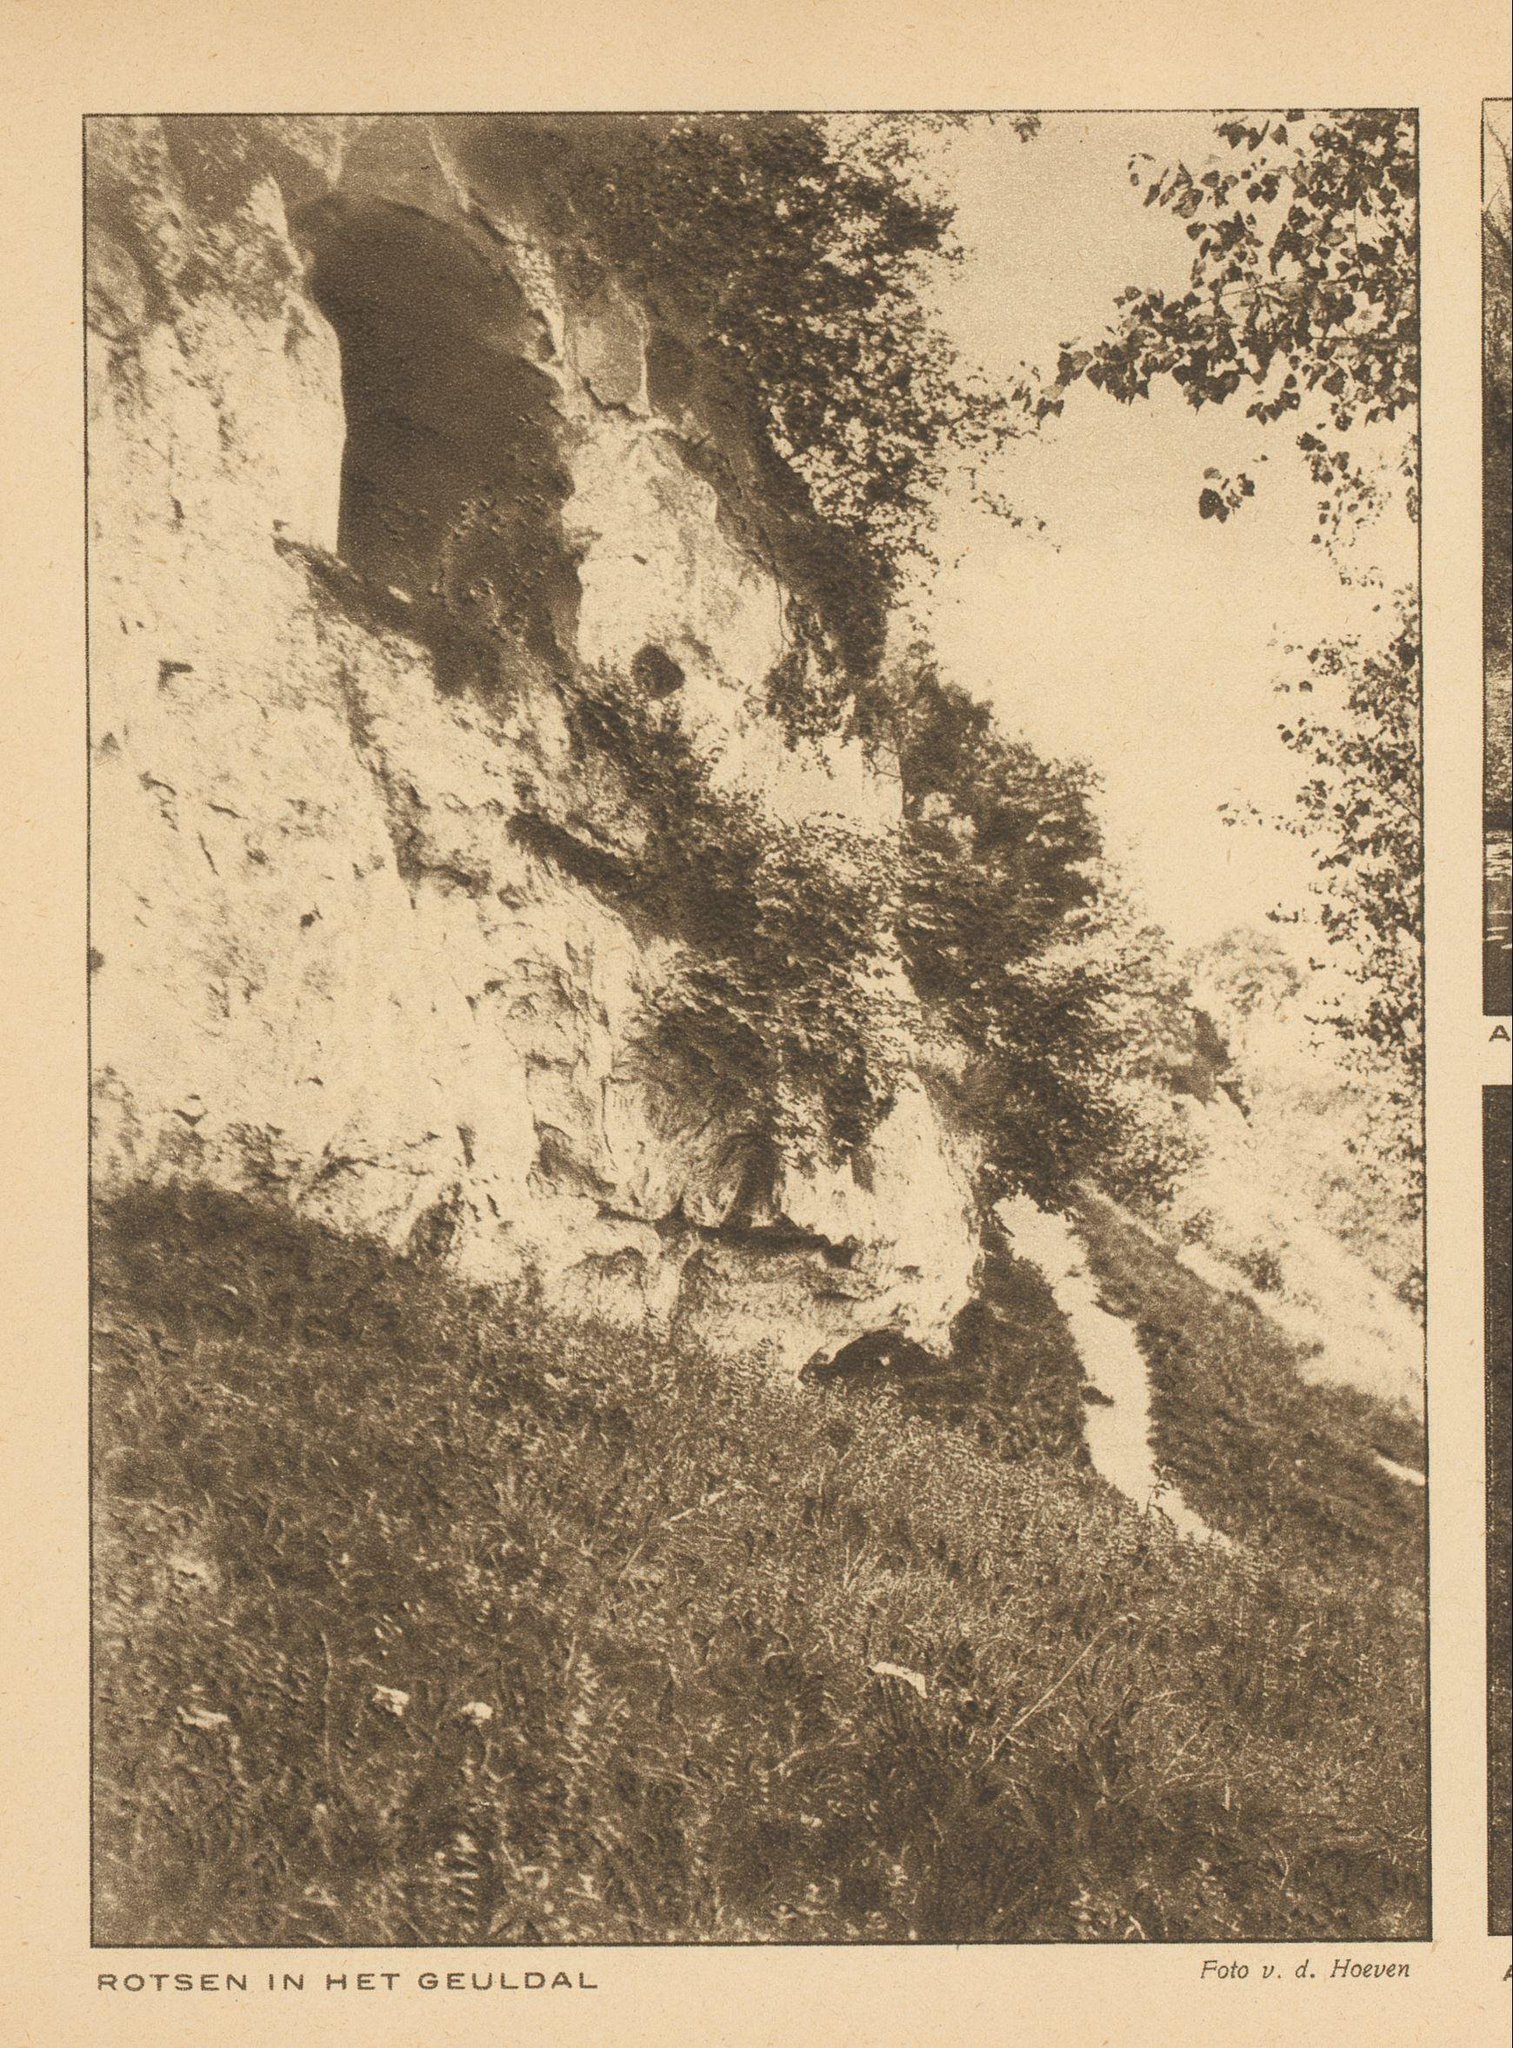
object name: photomechanical print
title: Rotsen in het Geuldal in Limburg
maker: v.d. hoeven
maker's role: fotograaf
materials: paper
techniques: rotogravure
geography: limburg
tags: dale, valley, rock-formations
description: Deze prent maakt deel uit van een album.